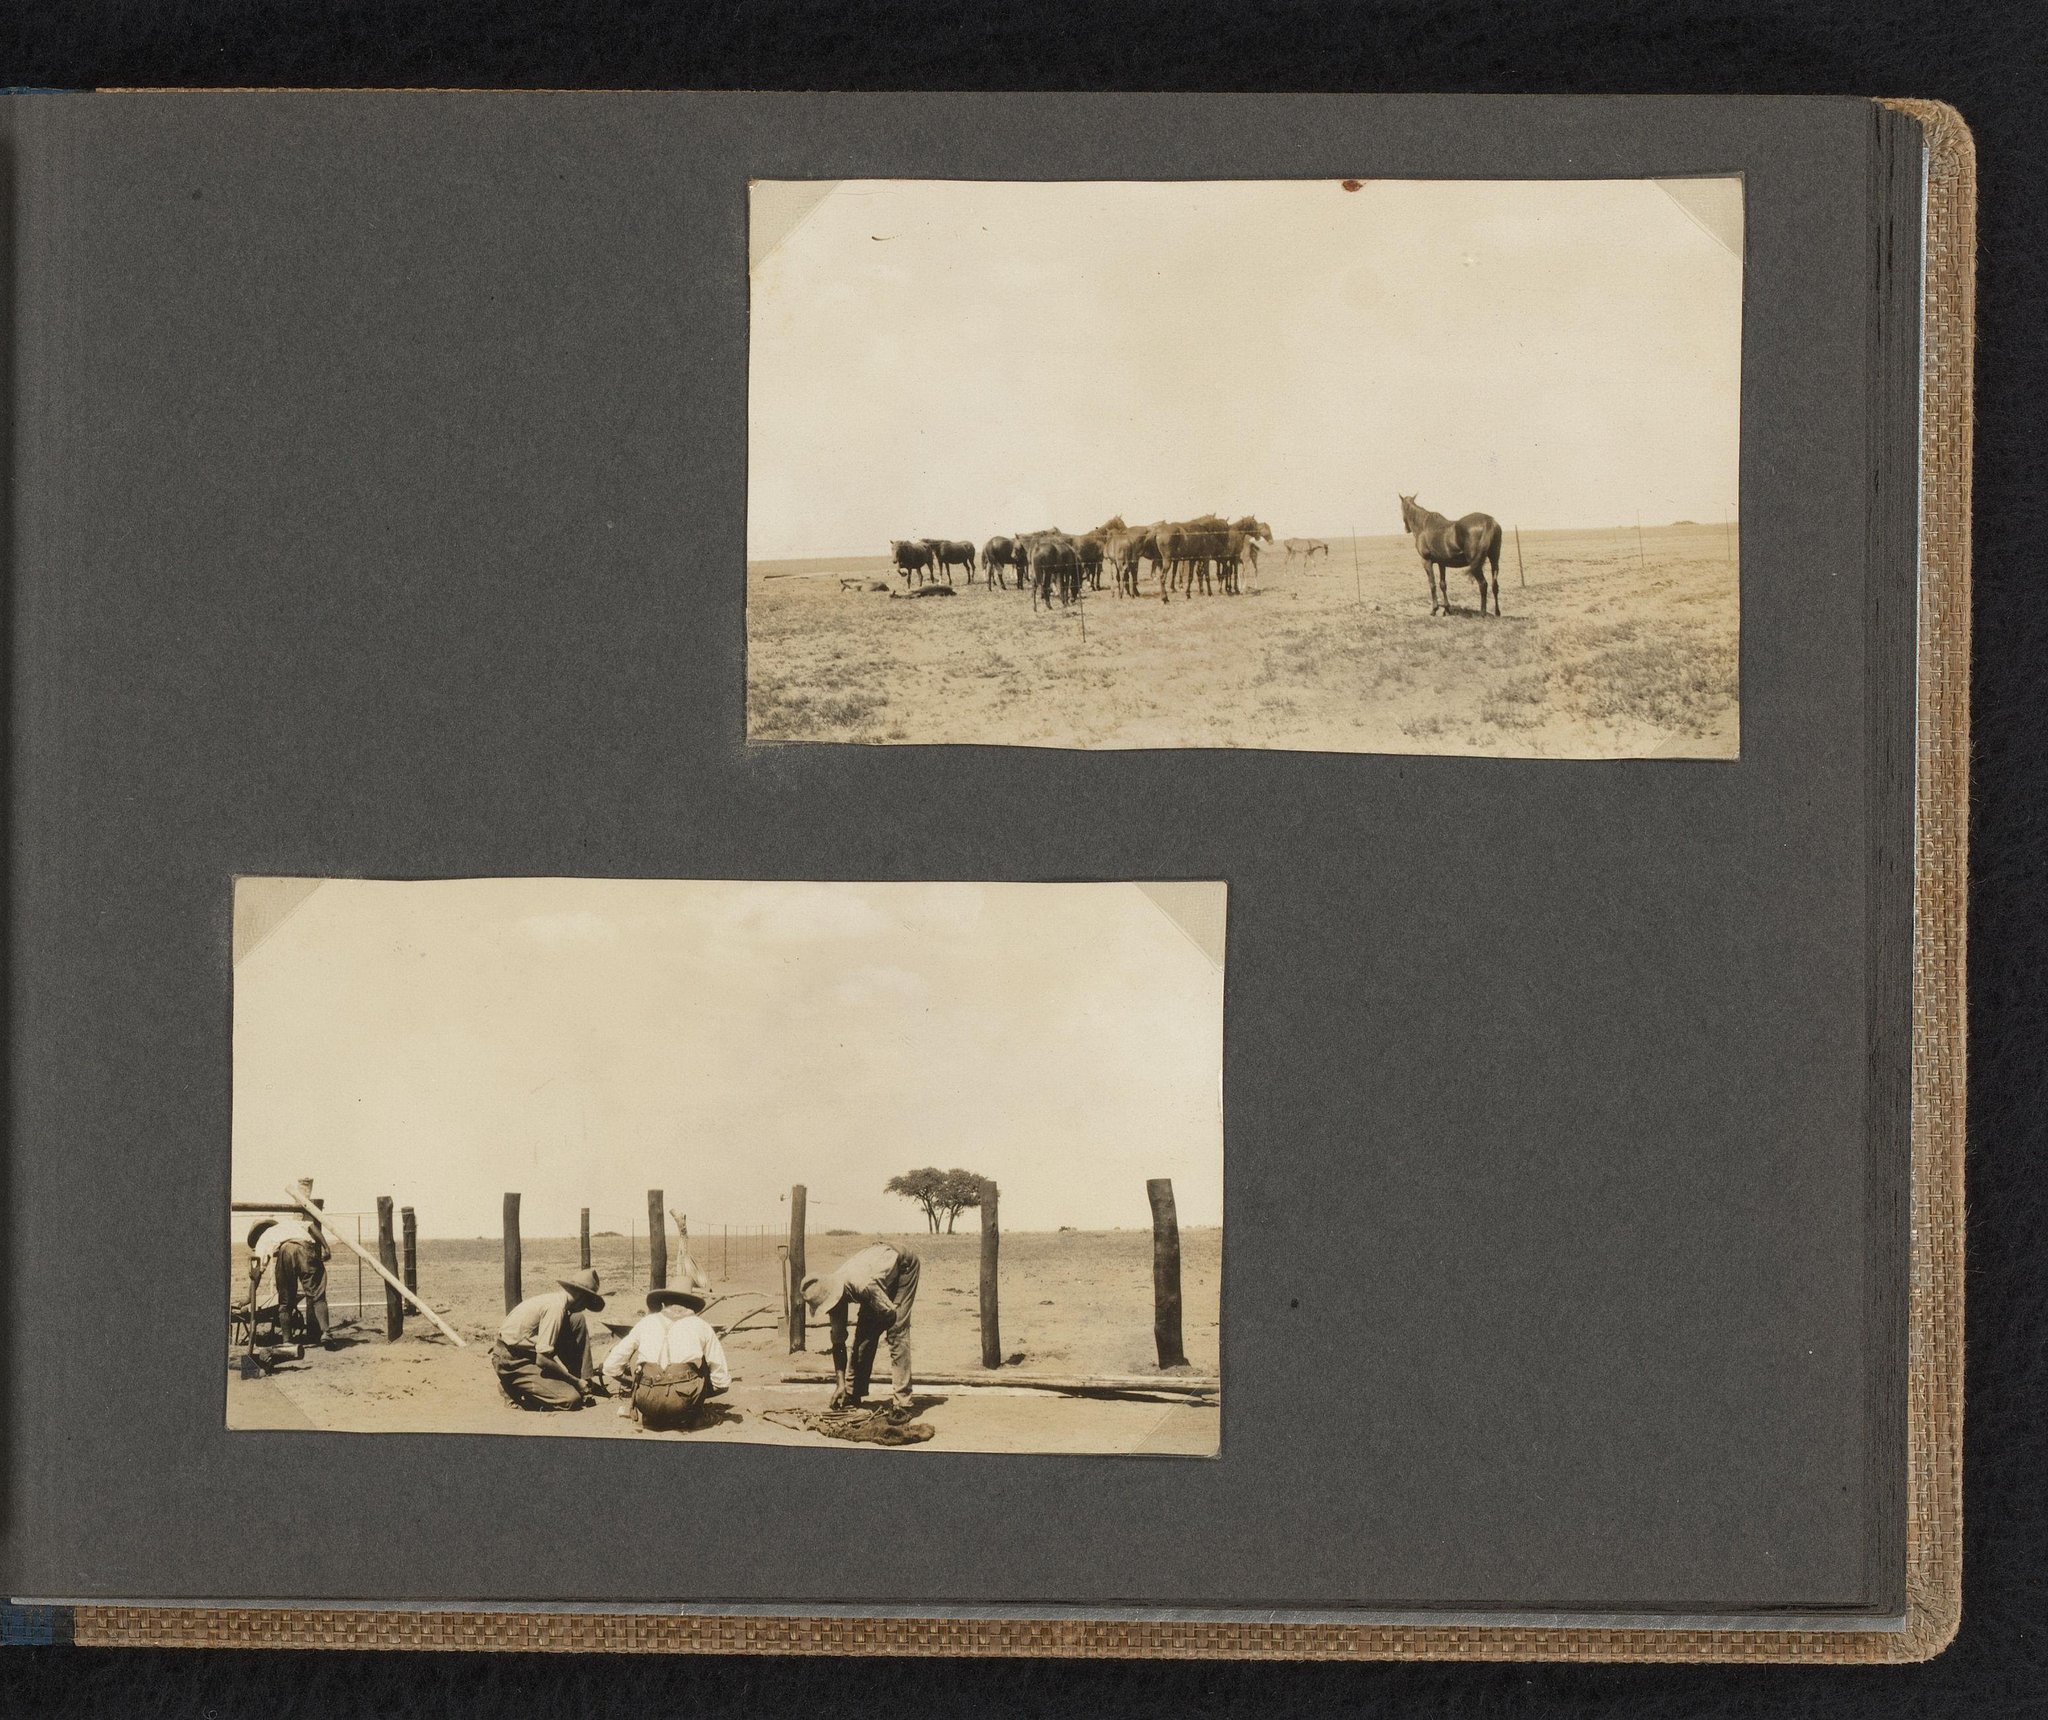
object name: album leaf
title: Werklui maken een hek rondom een veld met paarden, in Zuid-Afrika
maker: karel frederik van den berg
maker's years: 1873-1948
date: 1920-1930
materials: paper, cardboard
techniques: gelatin silver print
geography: south africa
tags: fence, wall, paling, horse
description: Deze foto's zijn onderdeel van een album.